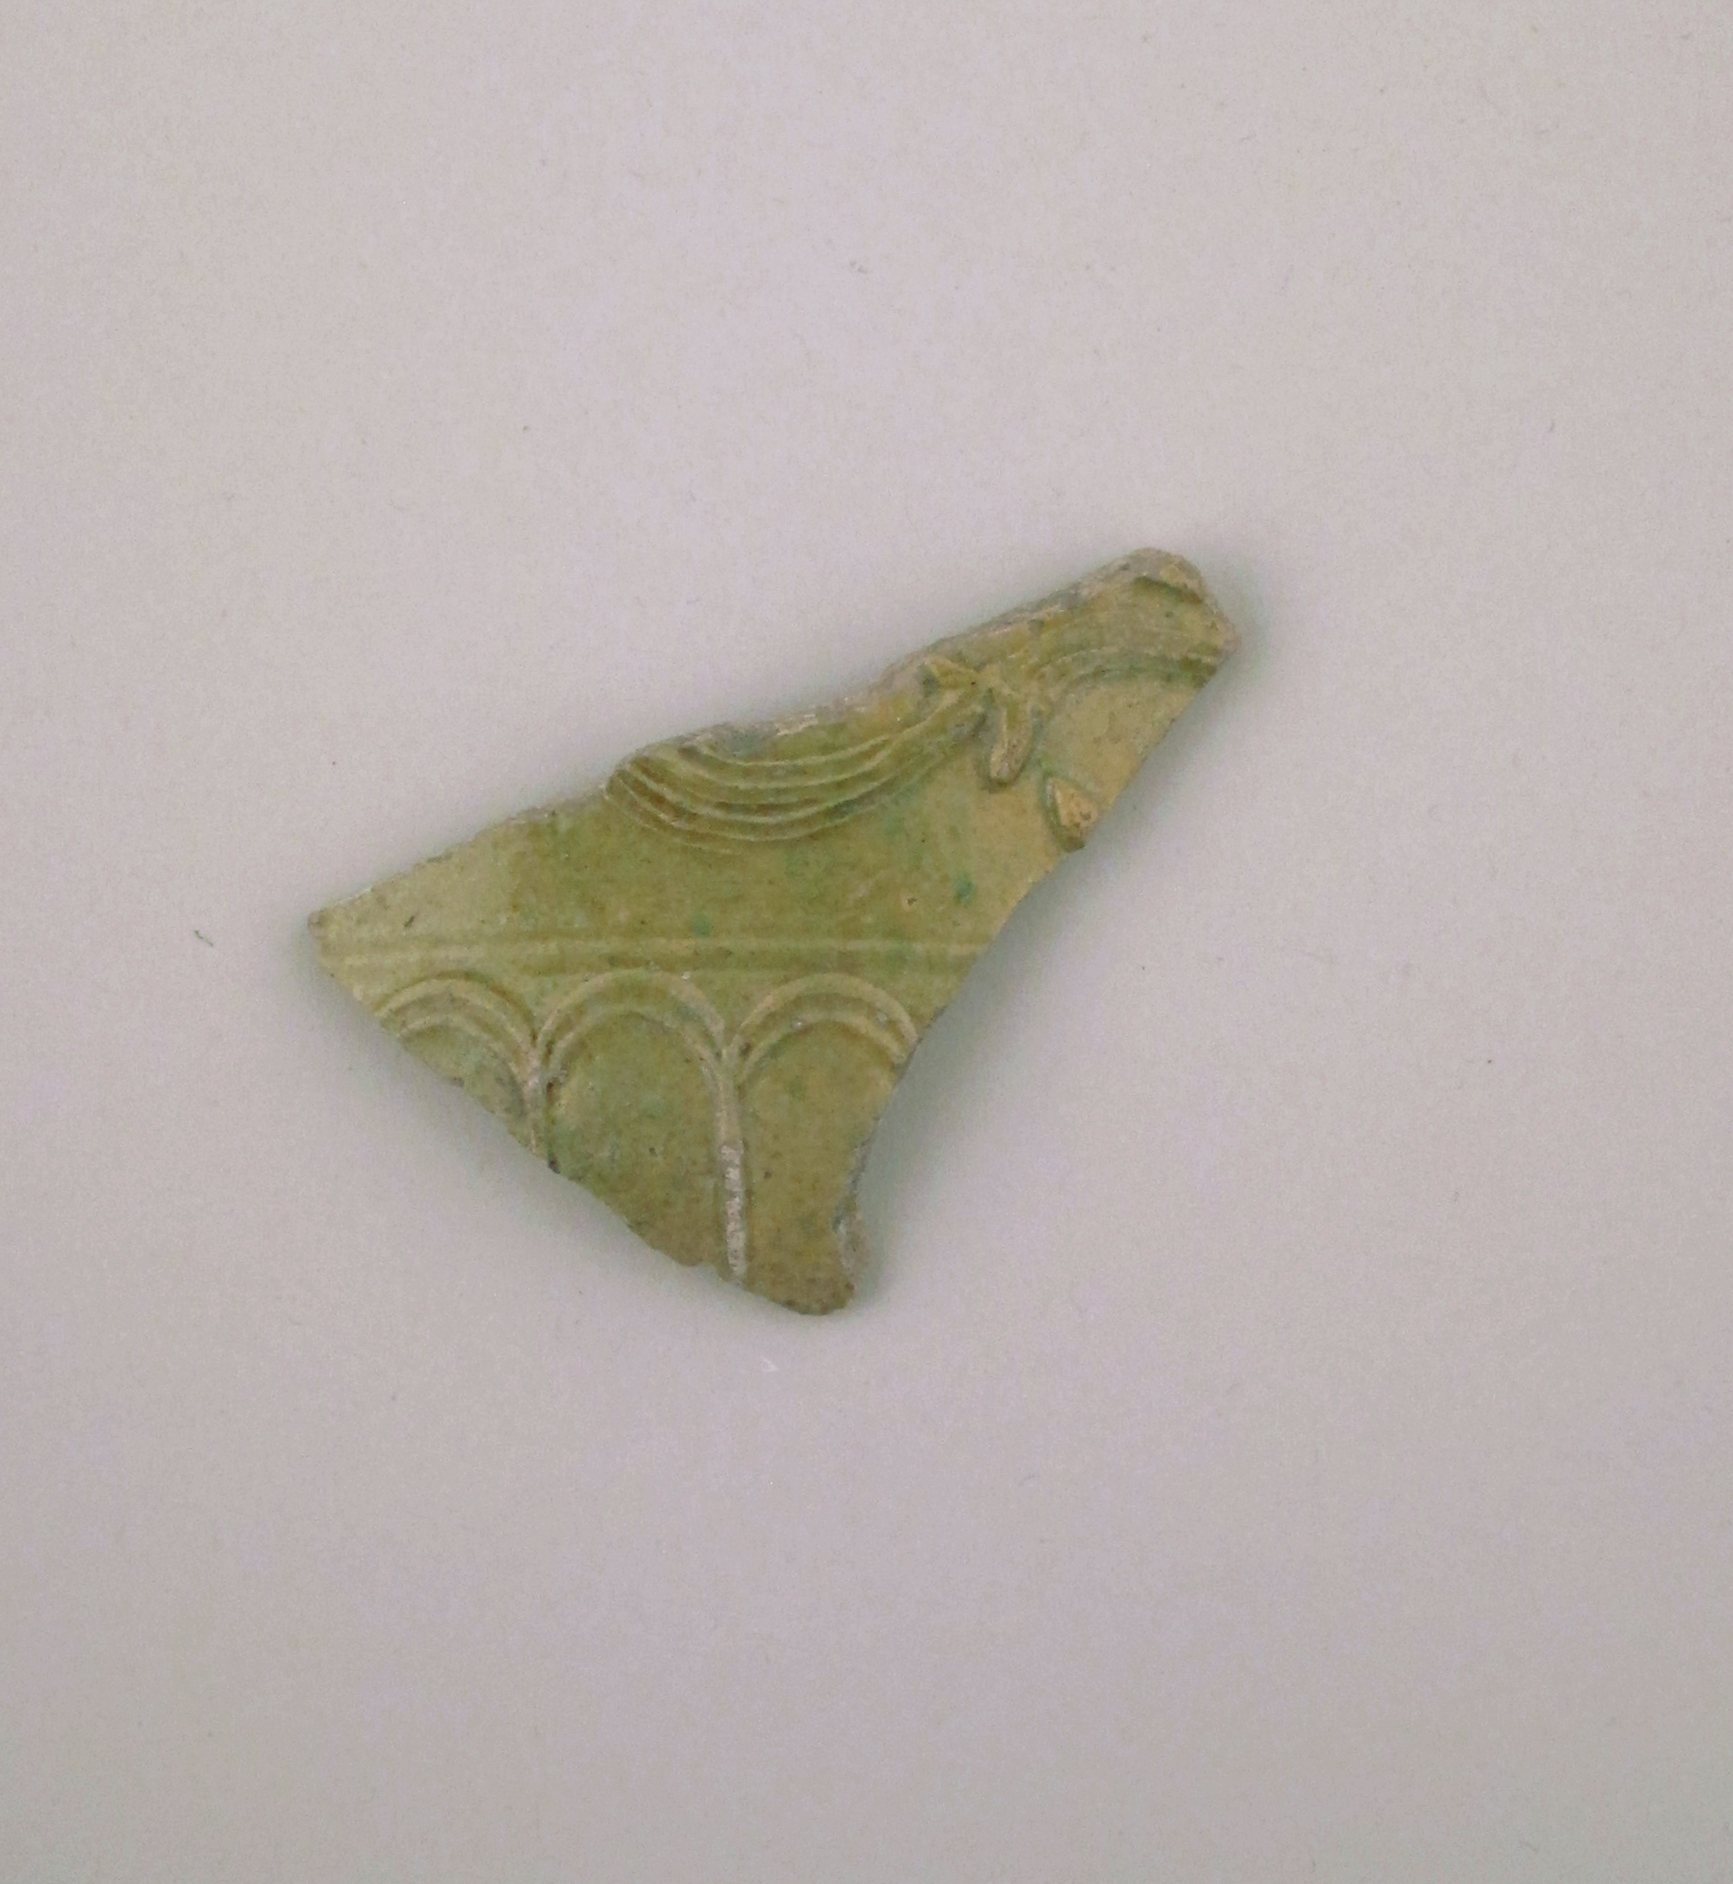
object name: vase fragment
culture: roman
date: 670 BCE-330 CE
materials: terracotta